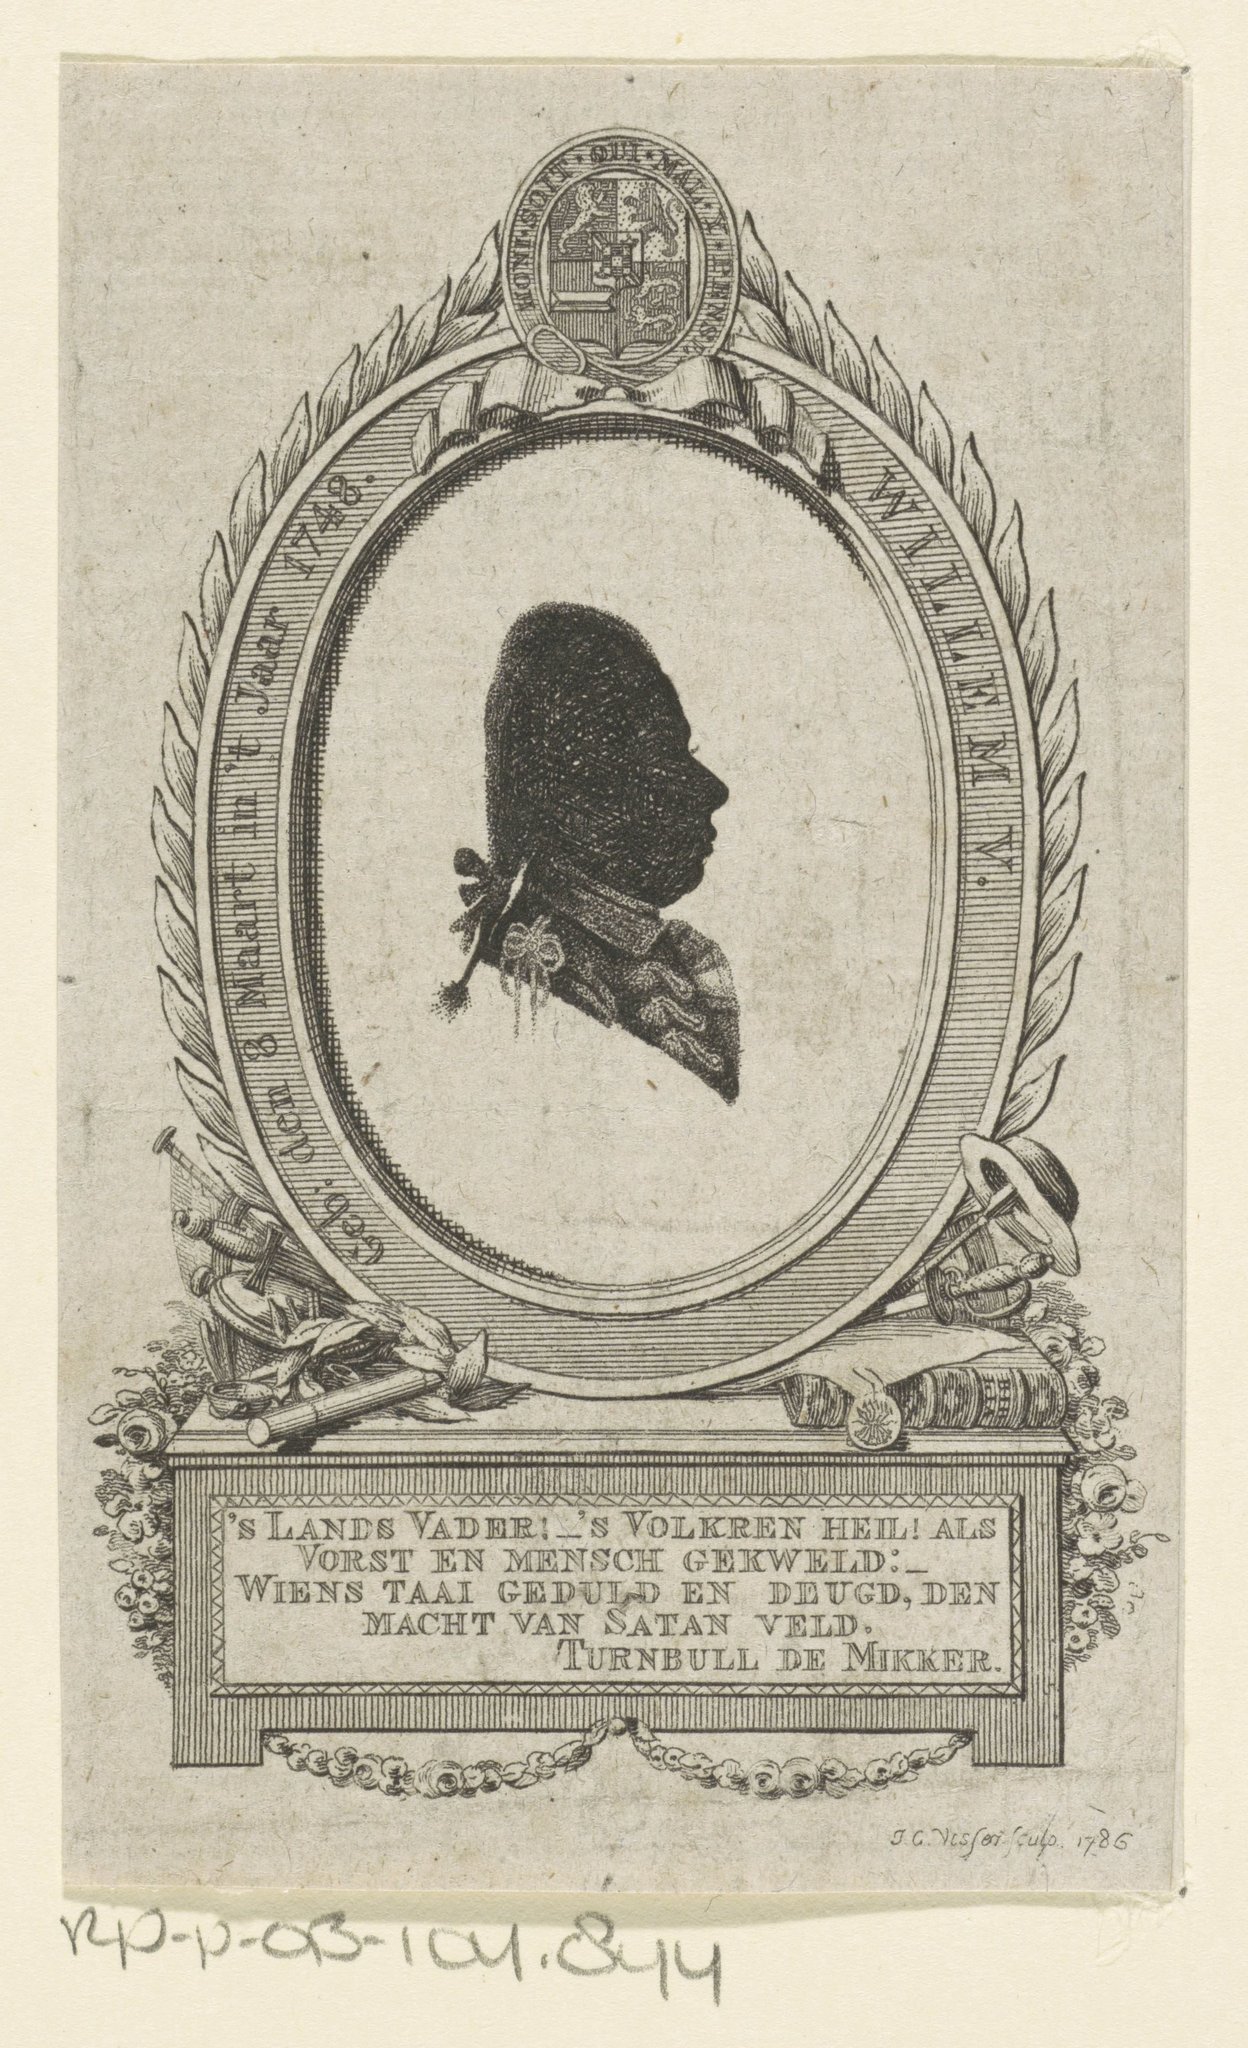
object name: print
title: Silhouetportret van Willem V, prins van Oranje-Nassau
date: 1786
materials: paper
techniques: engraving, etching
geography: amsterdam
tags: william v (prince of orange), knighthood order (garter) - insignia of a knighthood order, e.g.: badge, chain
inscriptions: date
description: Silhouetportret van Willem V in een ovaal met randschrift. Rondom ligt een aantal allegorische objecten. Midden boven zijn wapen, gedecoreerd met de Kousenband en het devies van de Orde van de Kousenband. Op een voetstuk vier regels Nederlandse tekst.